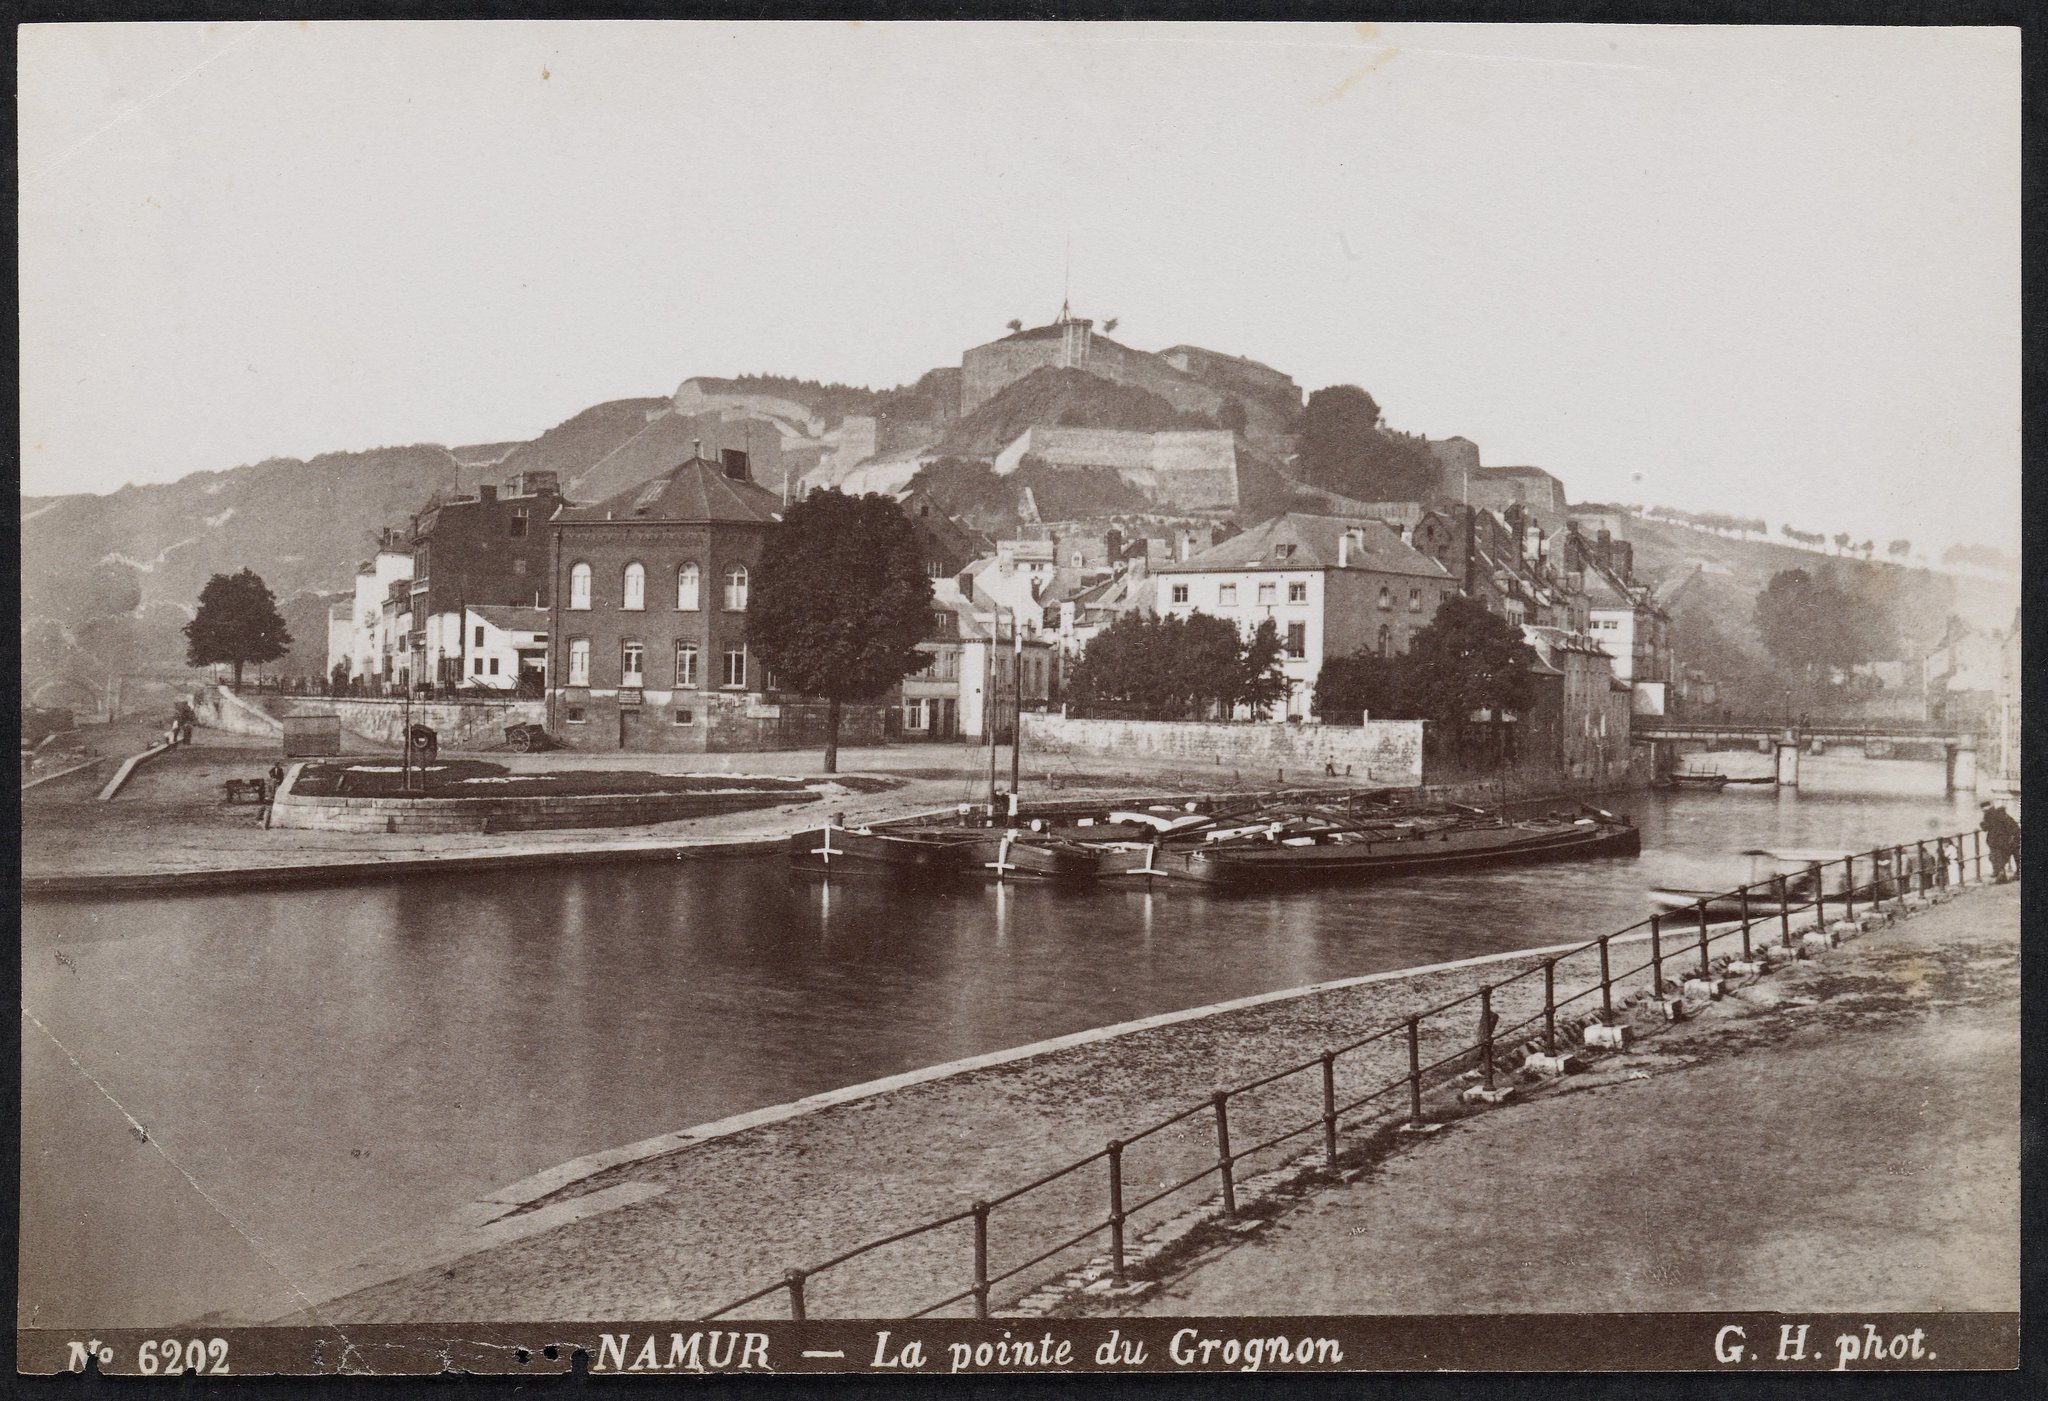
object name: photograph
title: Namur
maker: gustave hermans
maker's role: publisher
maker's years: 1856-1934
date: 1884-1914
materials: paper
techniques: albumen print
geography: namur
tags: city-view in general; 'veduta', river, fortified city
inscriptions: number: ‘No 6202’